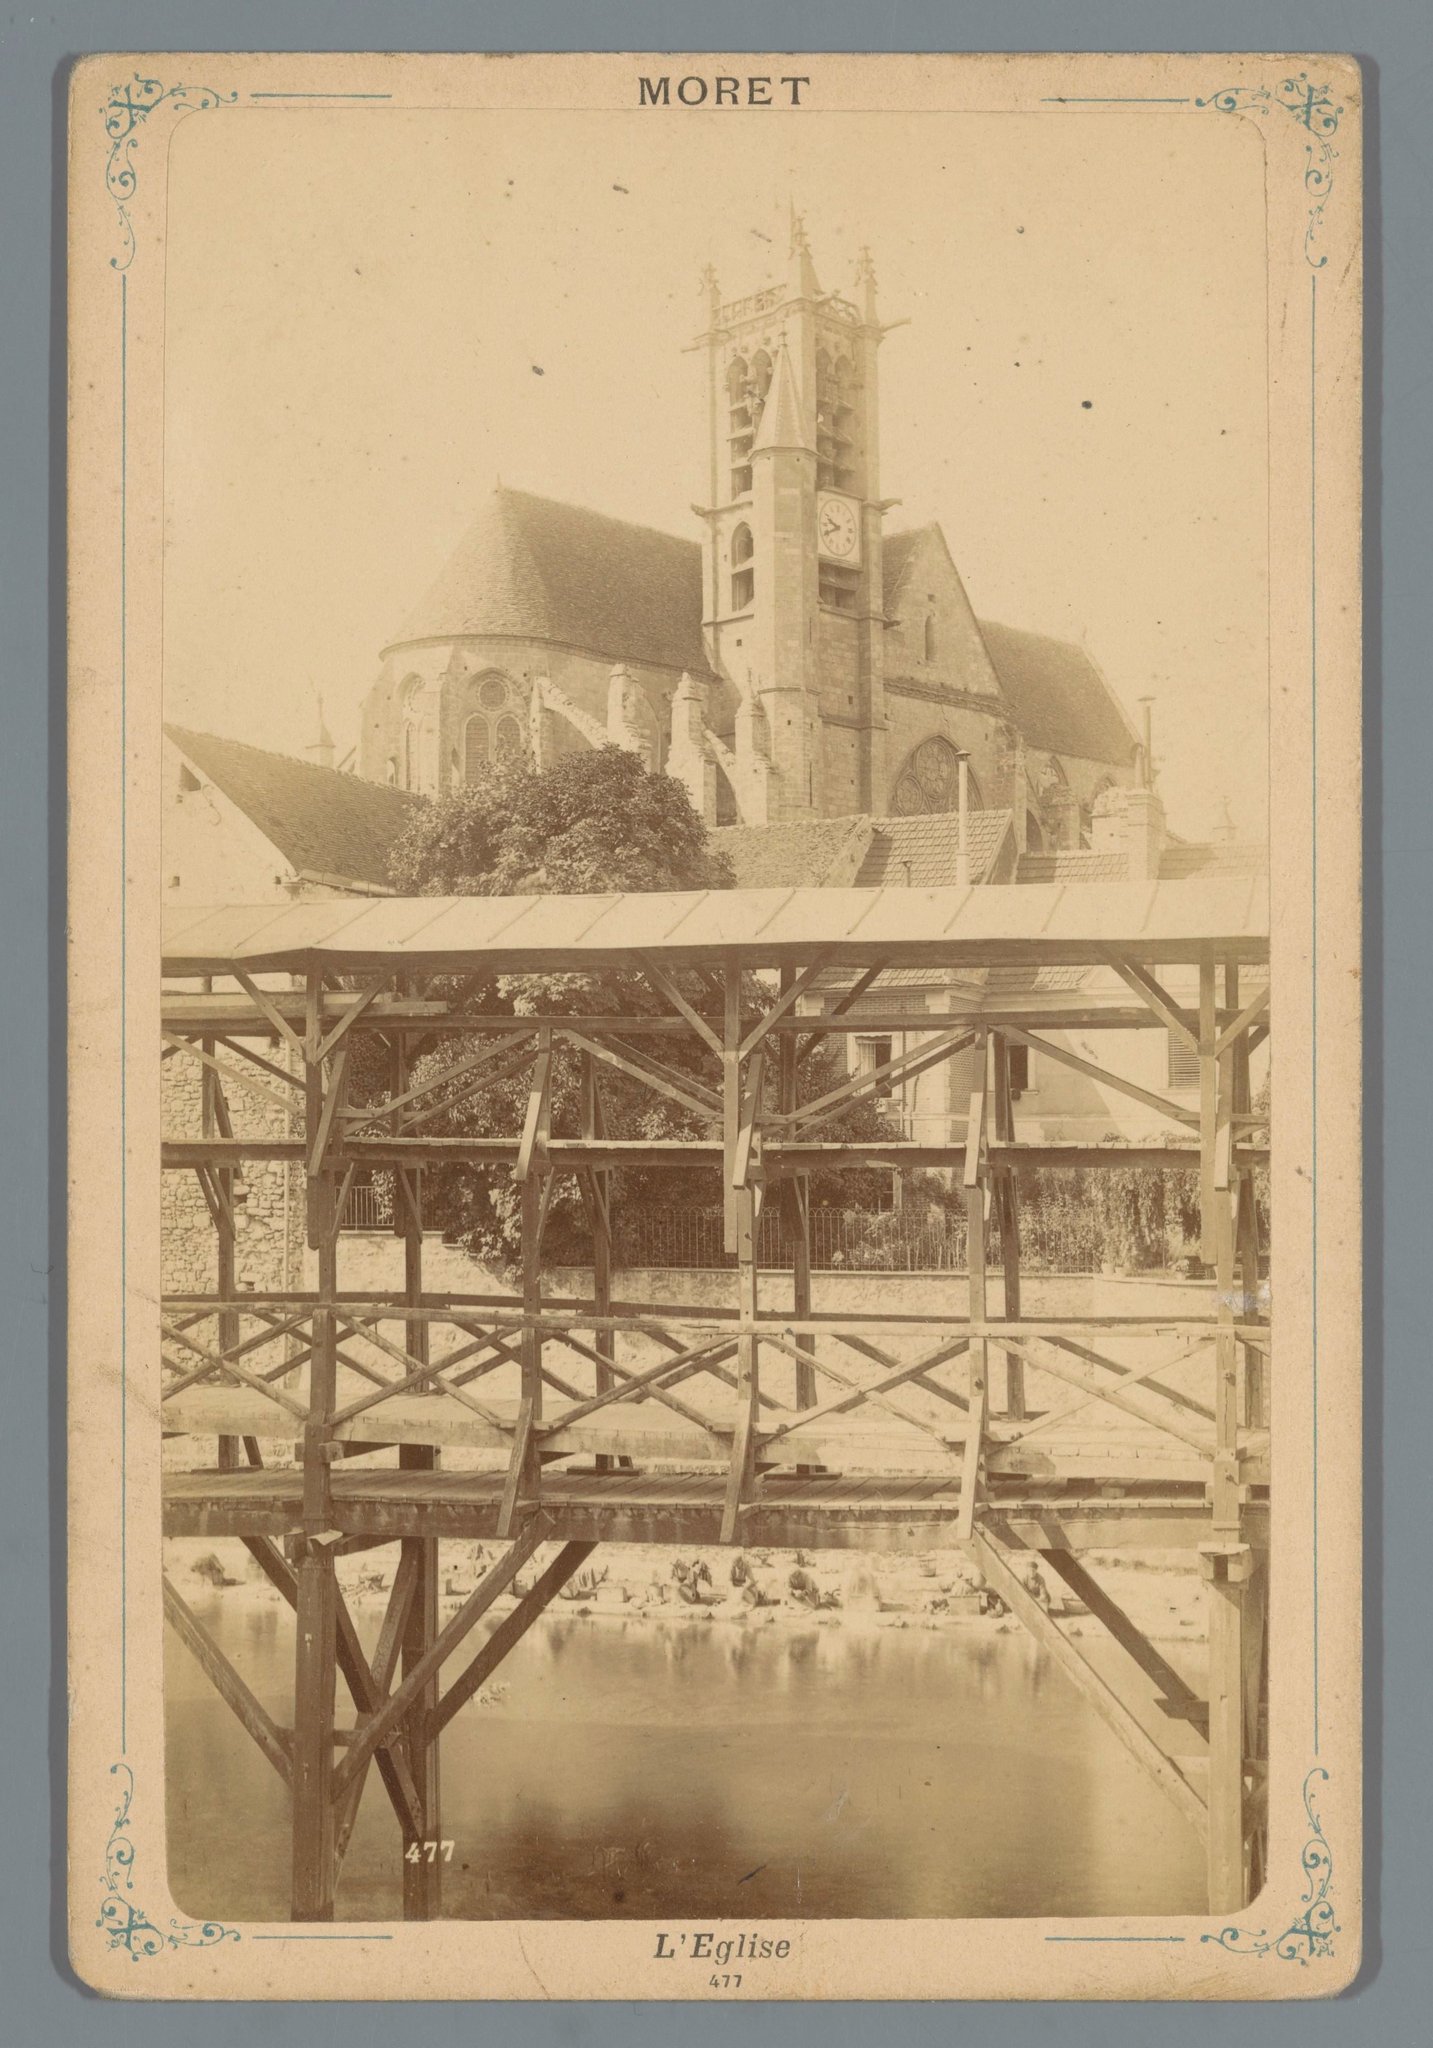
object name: cabinet photograph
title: Gezicht op een kerk te Moret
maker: étienne neurdein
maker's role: publisher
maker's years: 1832-1918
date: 1891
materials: cardboard, photographic support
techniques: albumen print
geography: moret-sur-loing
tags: church (exterior)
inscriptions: date: ‘Novembre 1891’, number: ‘477’, number: ‘477’